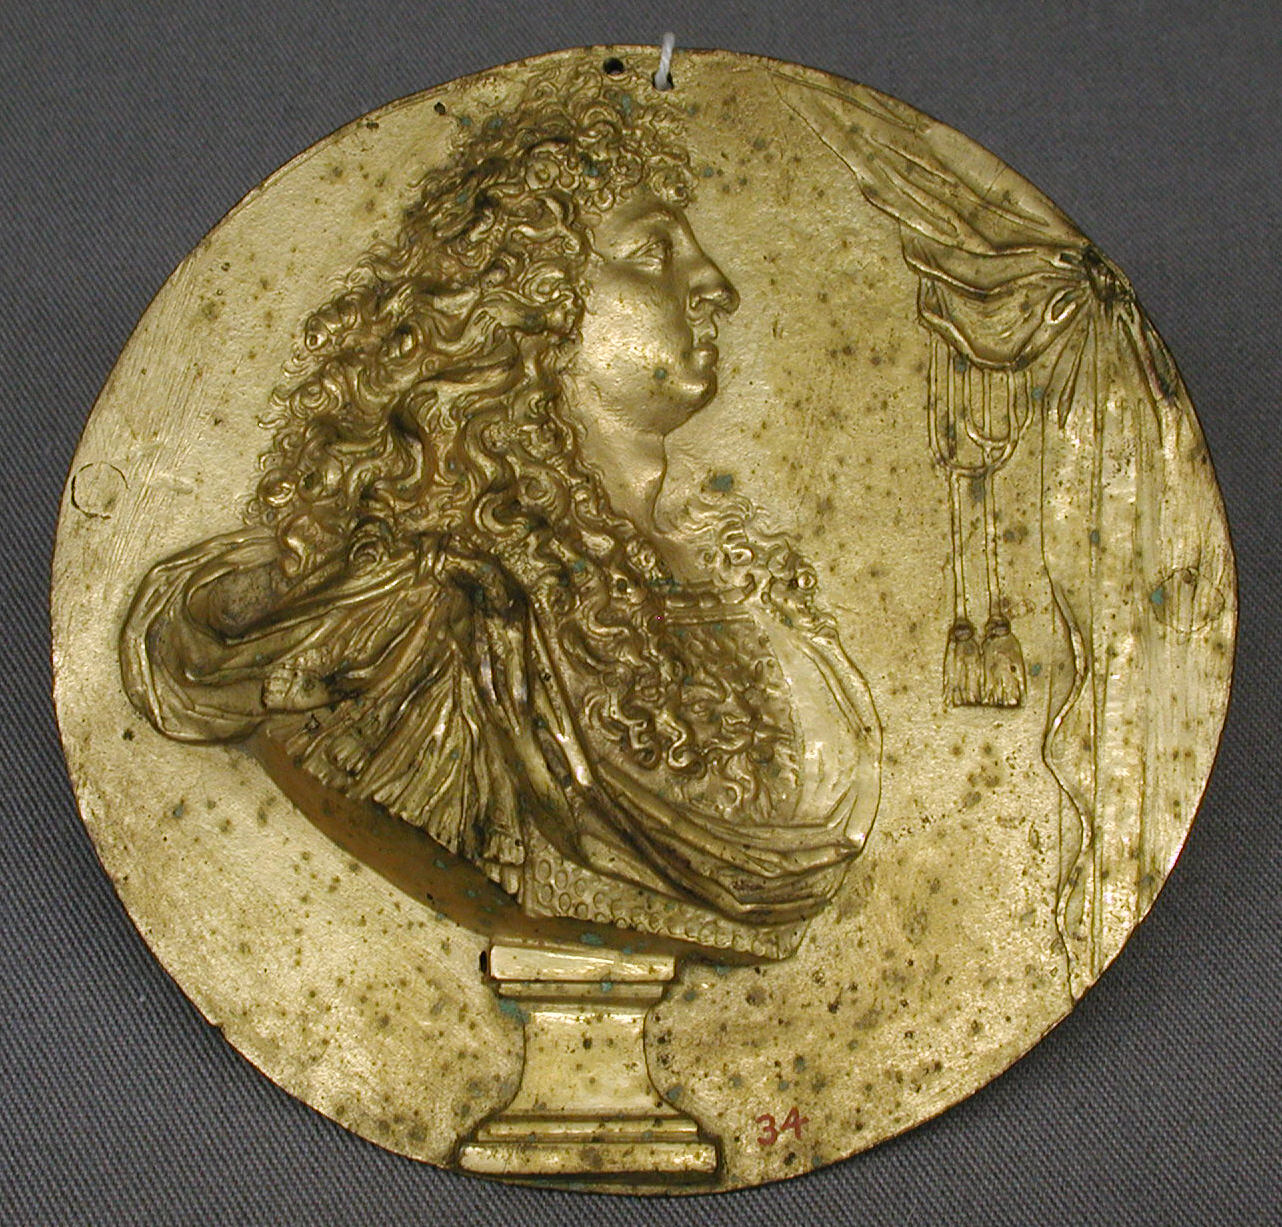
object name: medallion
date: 1601-1800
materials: gilt bronze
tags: men,profiles